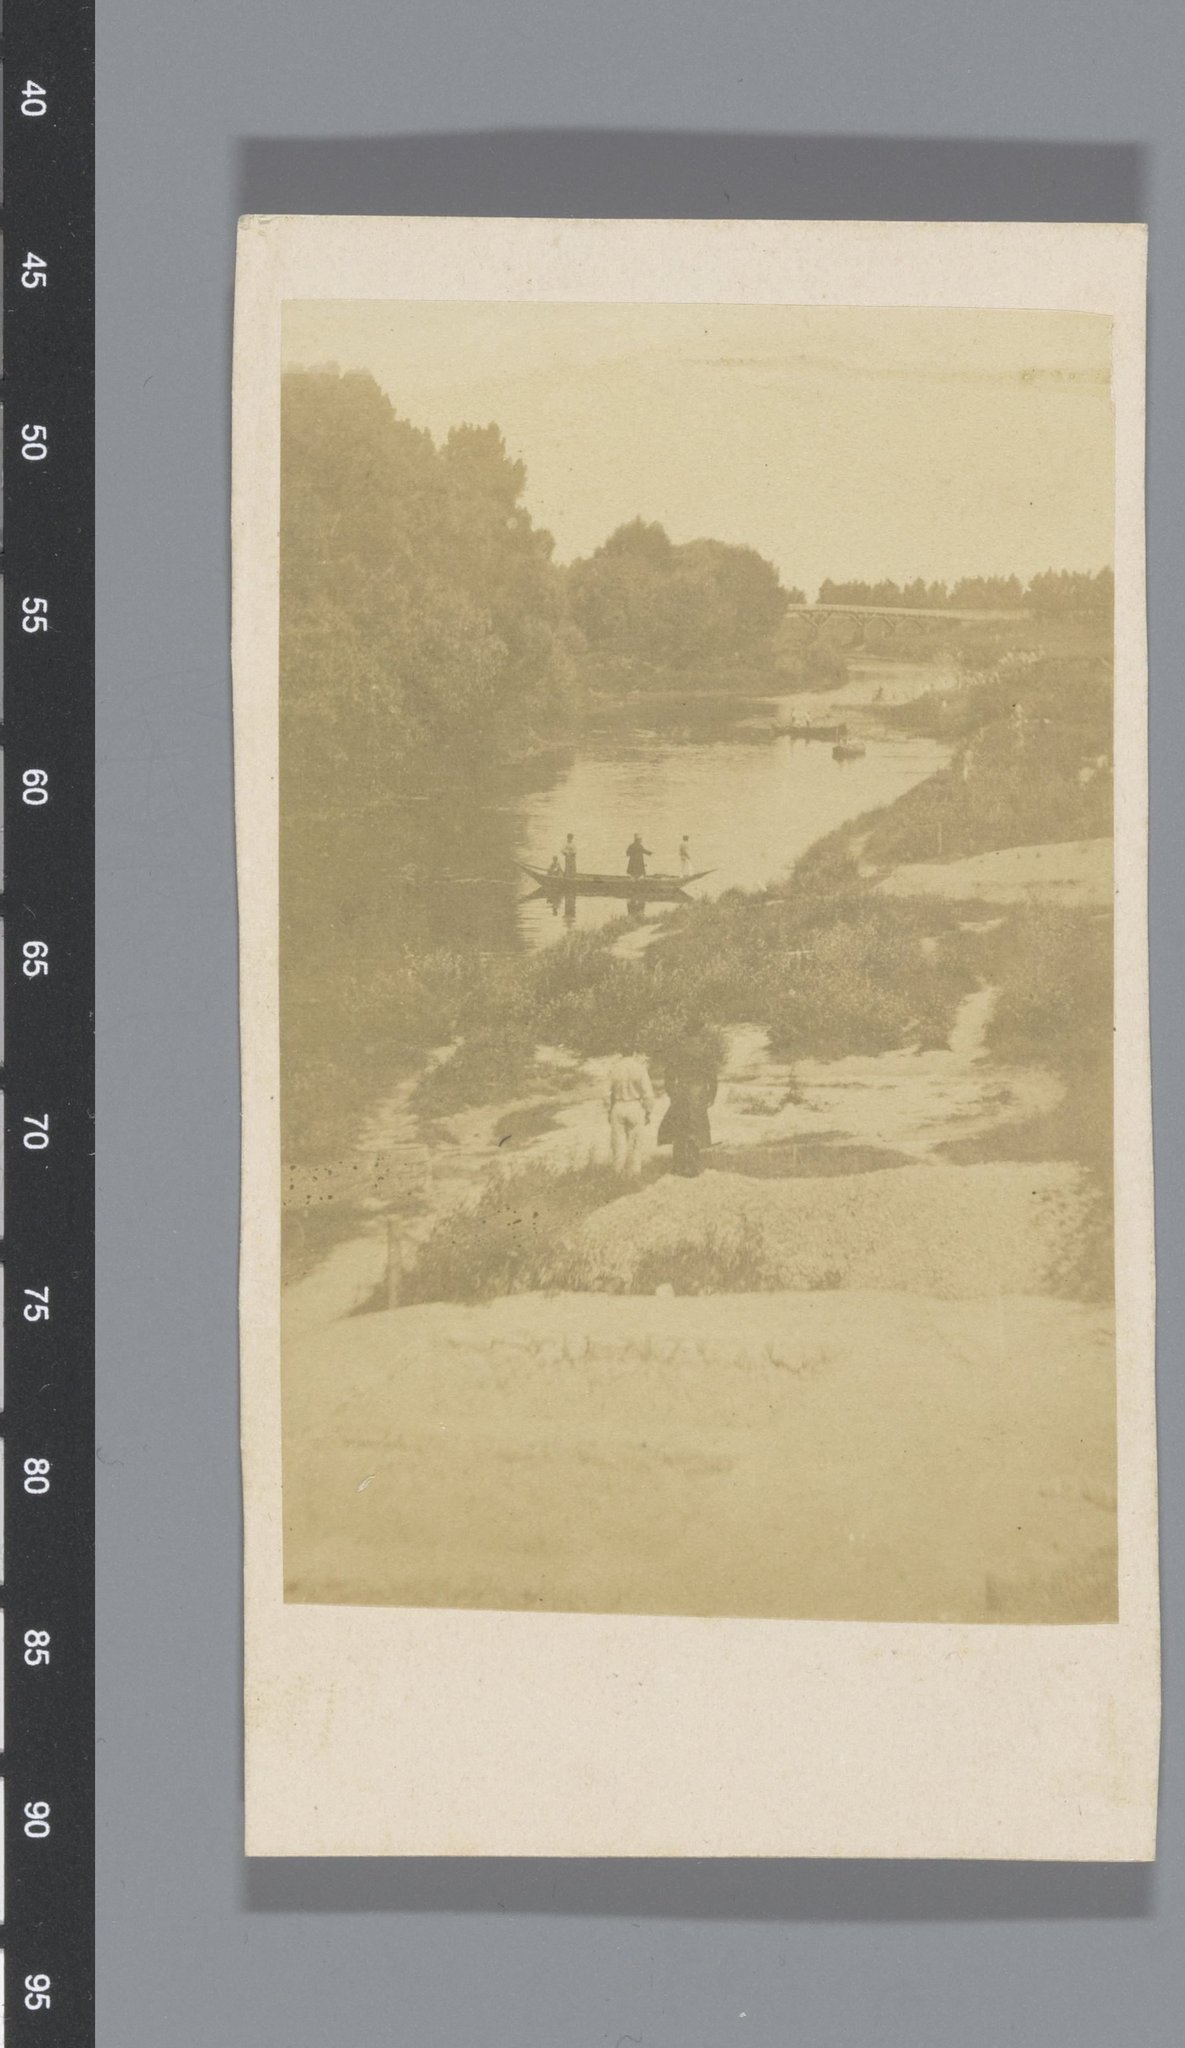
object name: photograph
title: Gezicht op de Seine te Meudon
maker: Anonymous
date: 1865-1870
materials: cardboard, paper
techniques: albumen print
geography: meudon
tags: water course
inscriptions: inscription: ‘Bas Meudon’